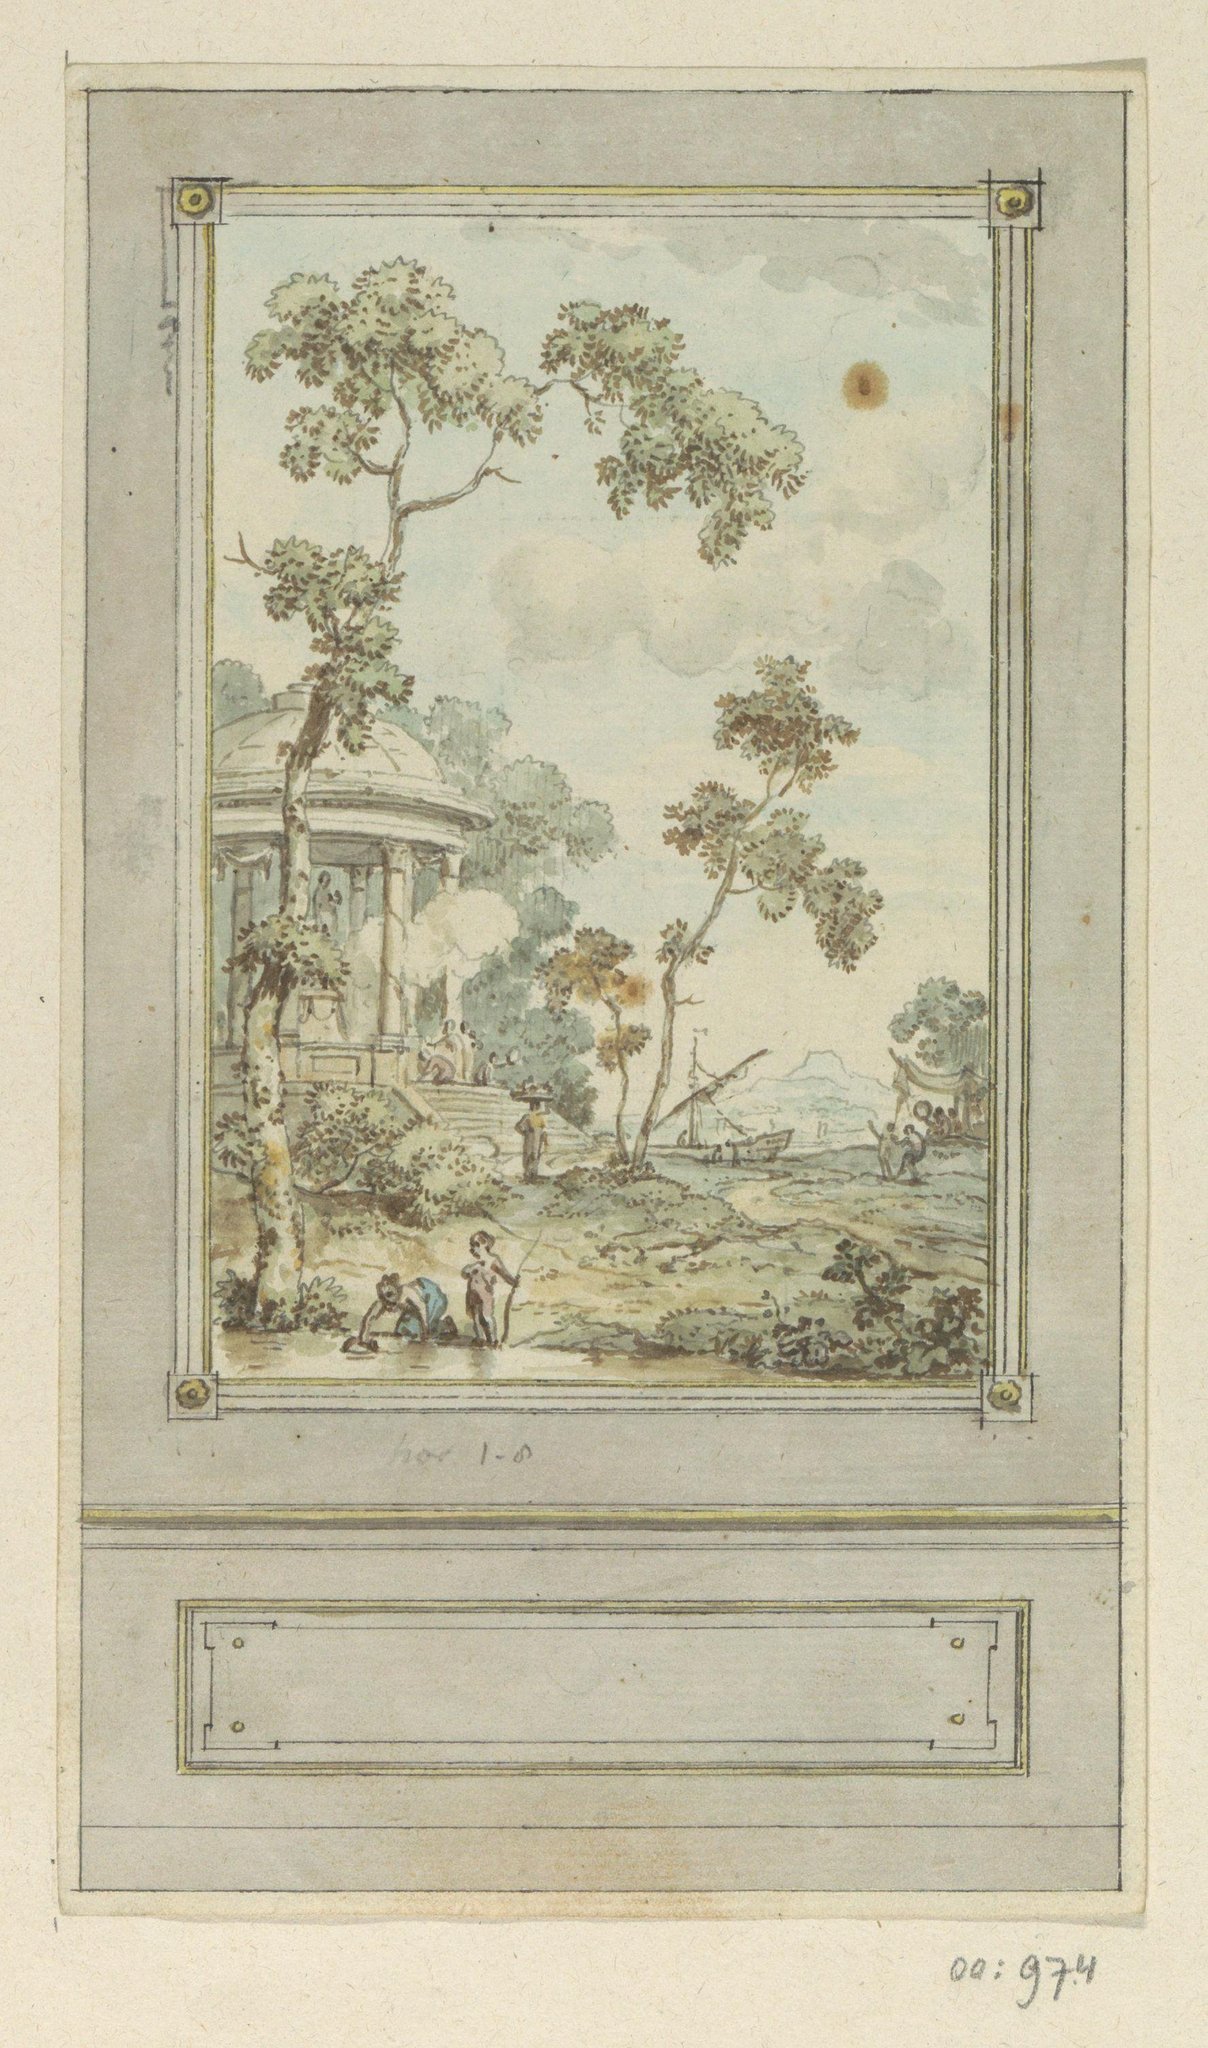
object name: album leaf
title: Ontwerptekening voor een kamerwand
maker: jurriaan andriessen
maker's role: draughtsman, painter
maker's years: 1742-1819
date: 1760-1819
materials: paint, paper, pencil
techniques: brush, pen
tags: landscapes in the temperate zone, wall-covering, pastorals, arcadian scenes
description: Met een arcadisch landschap. Tekening maakt deel uit van een album.